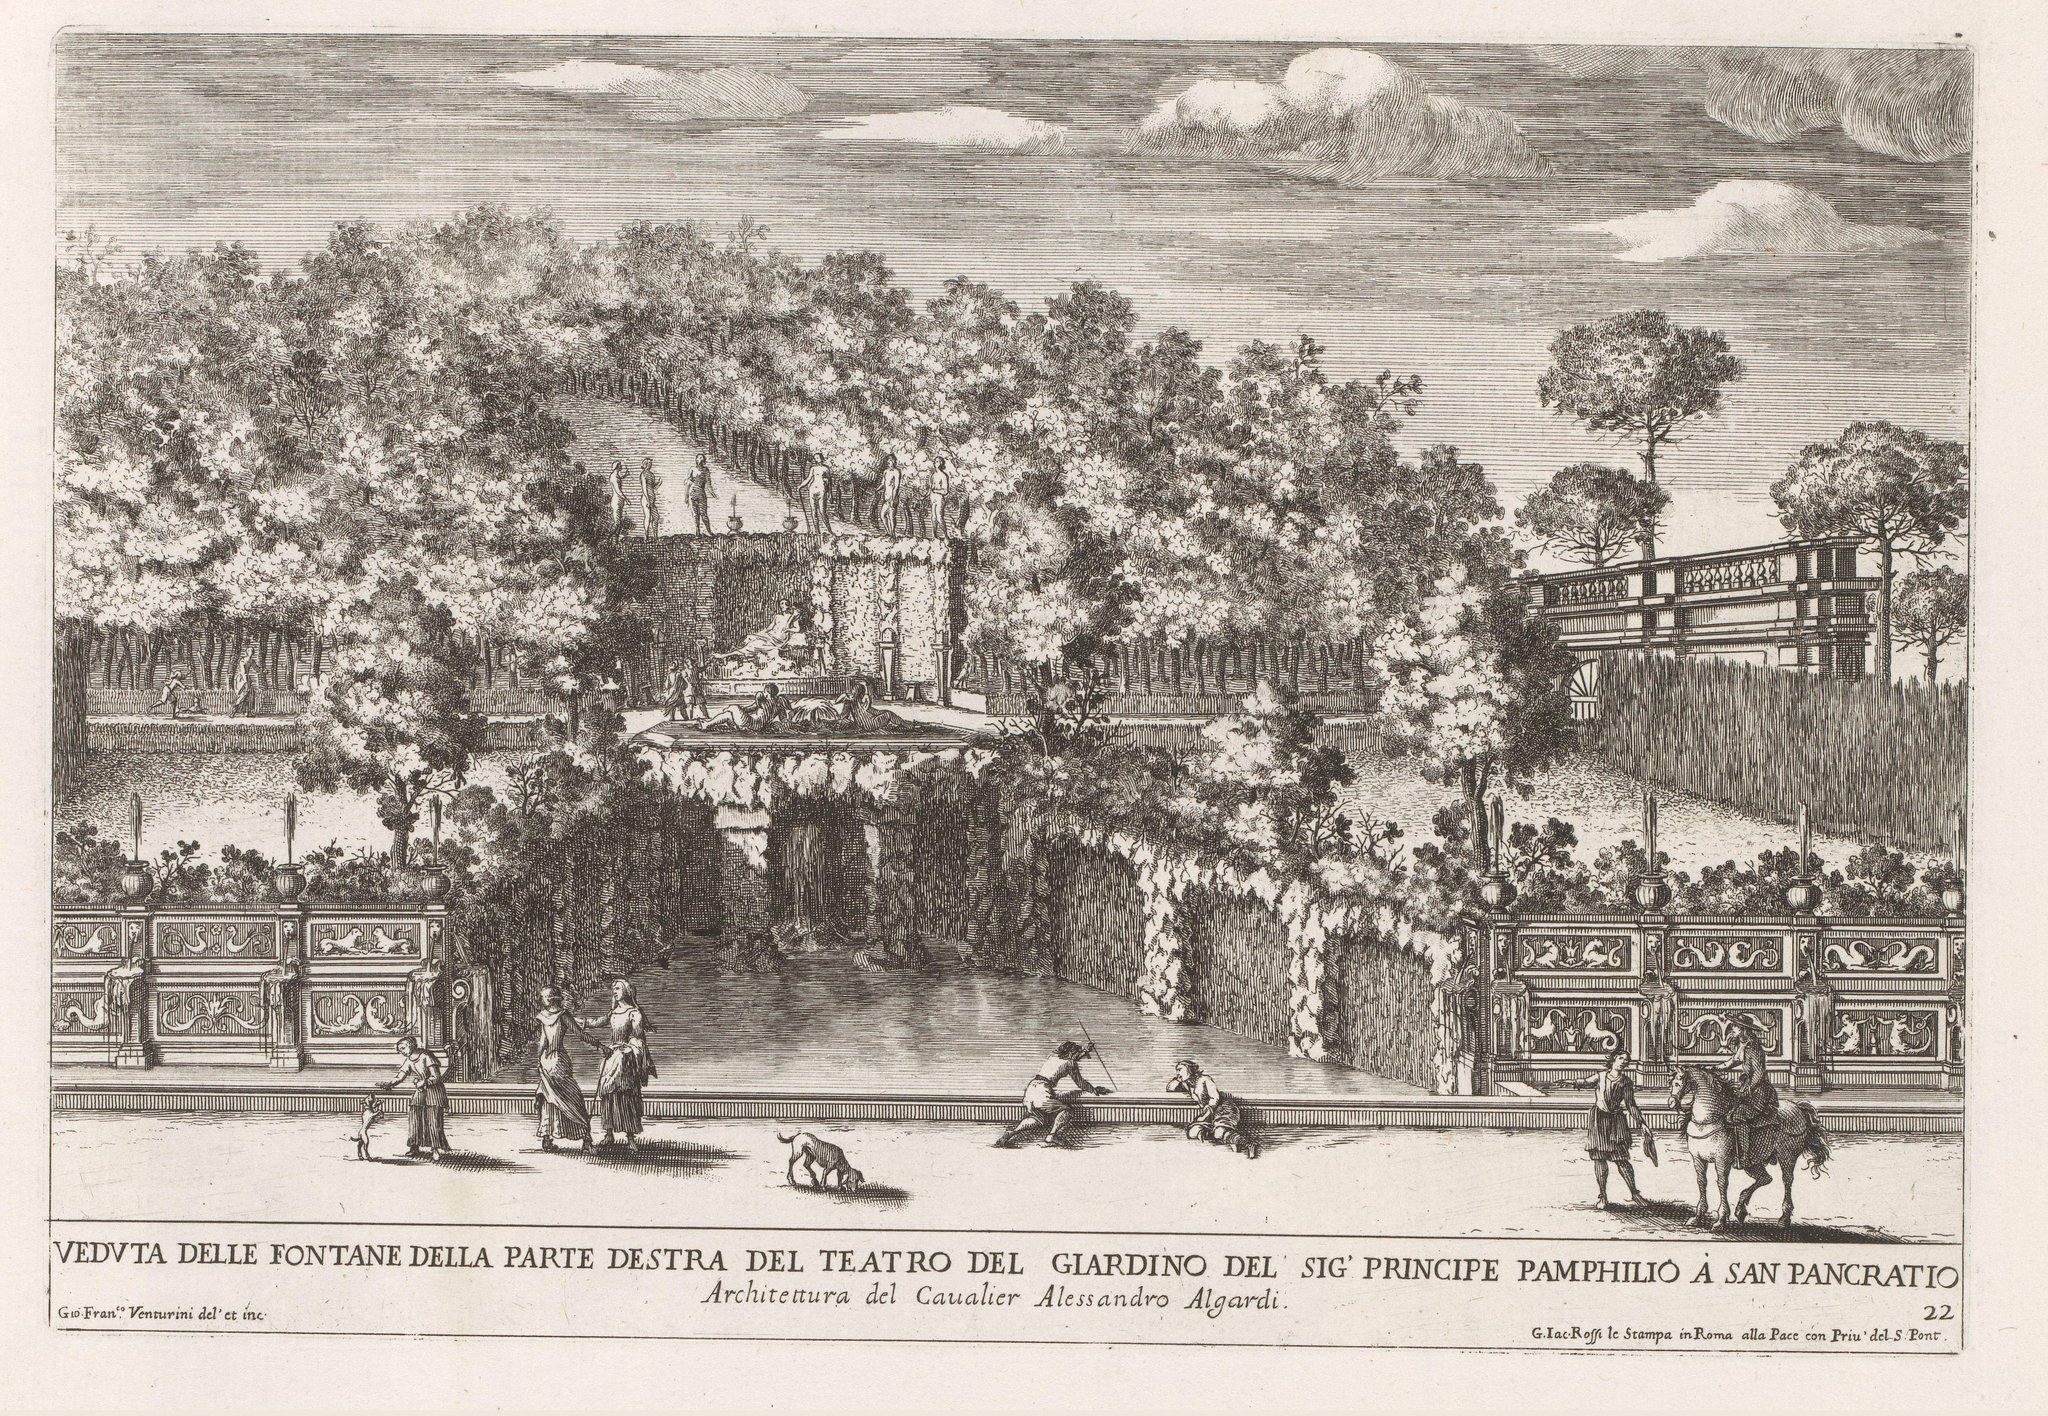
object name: album leaf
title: Fontein in de tuinen van Villa Doria Pamphilj te Rome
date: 1653-1691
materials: paper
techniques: etching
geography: vatican city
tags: ornamental fountain, rome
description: Genummerd rechtsonder: 22. De prent maakt deel uit van een album.